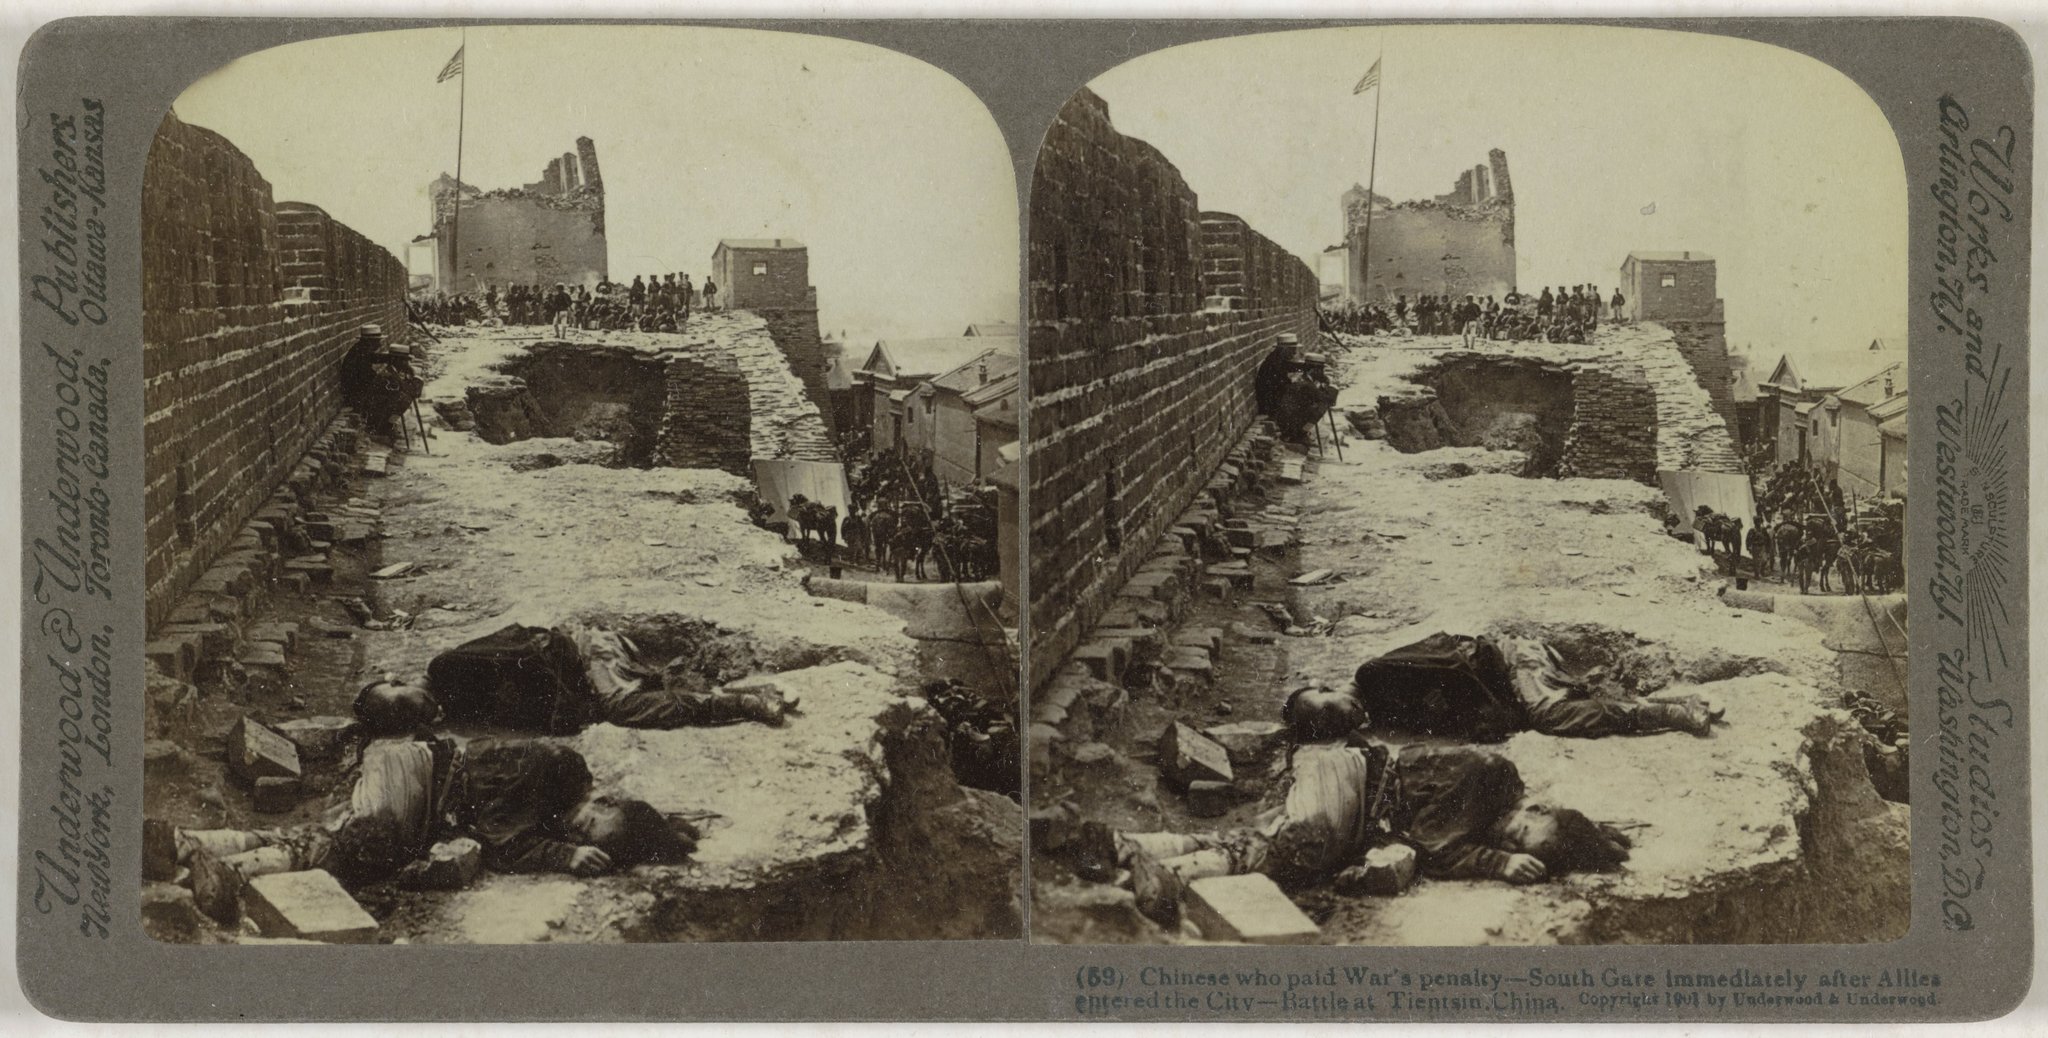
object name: stereograph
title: Victims of the Battle at Tientsin in China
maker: Anonymous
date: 1900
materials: cardboard, paper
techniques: albumen print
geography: new york city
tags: death of human being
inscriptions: inscription: ‘SUN SCULPTURE/ UU/ TRADEMARK/ Works and Studios/ Arlington, N.J. Westwood, N.J. Washington, D.C.’, title: ‘Chinese people Paid War's Penalty; Tientsin, China.’, inscription: ‘We are just inside the southern wall of the/ native city" at Tientsin. July 14, 1900. It has/ been fiercely besieged by (...)’, number: ‘59’, copyright notice: ‘Copyright 1901 by Underwood & Underwood.’